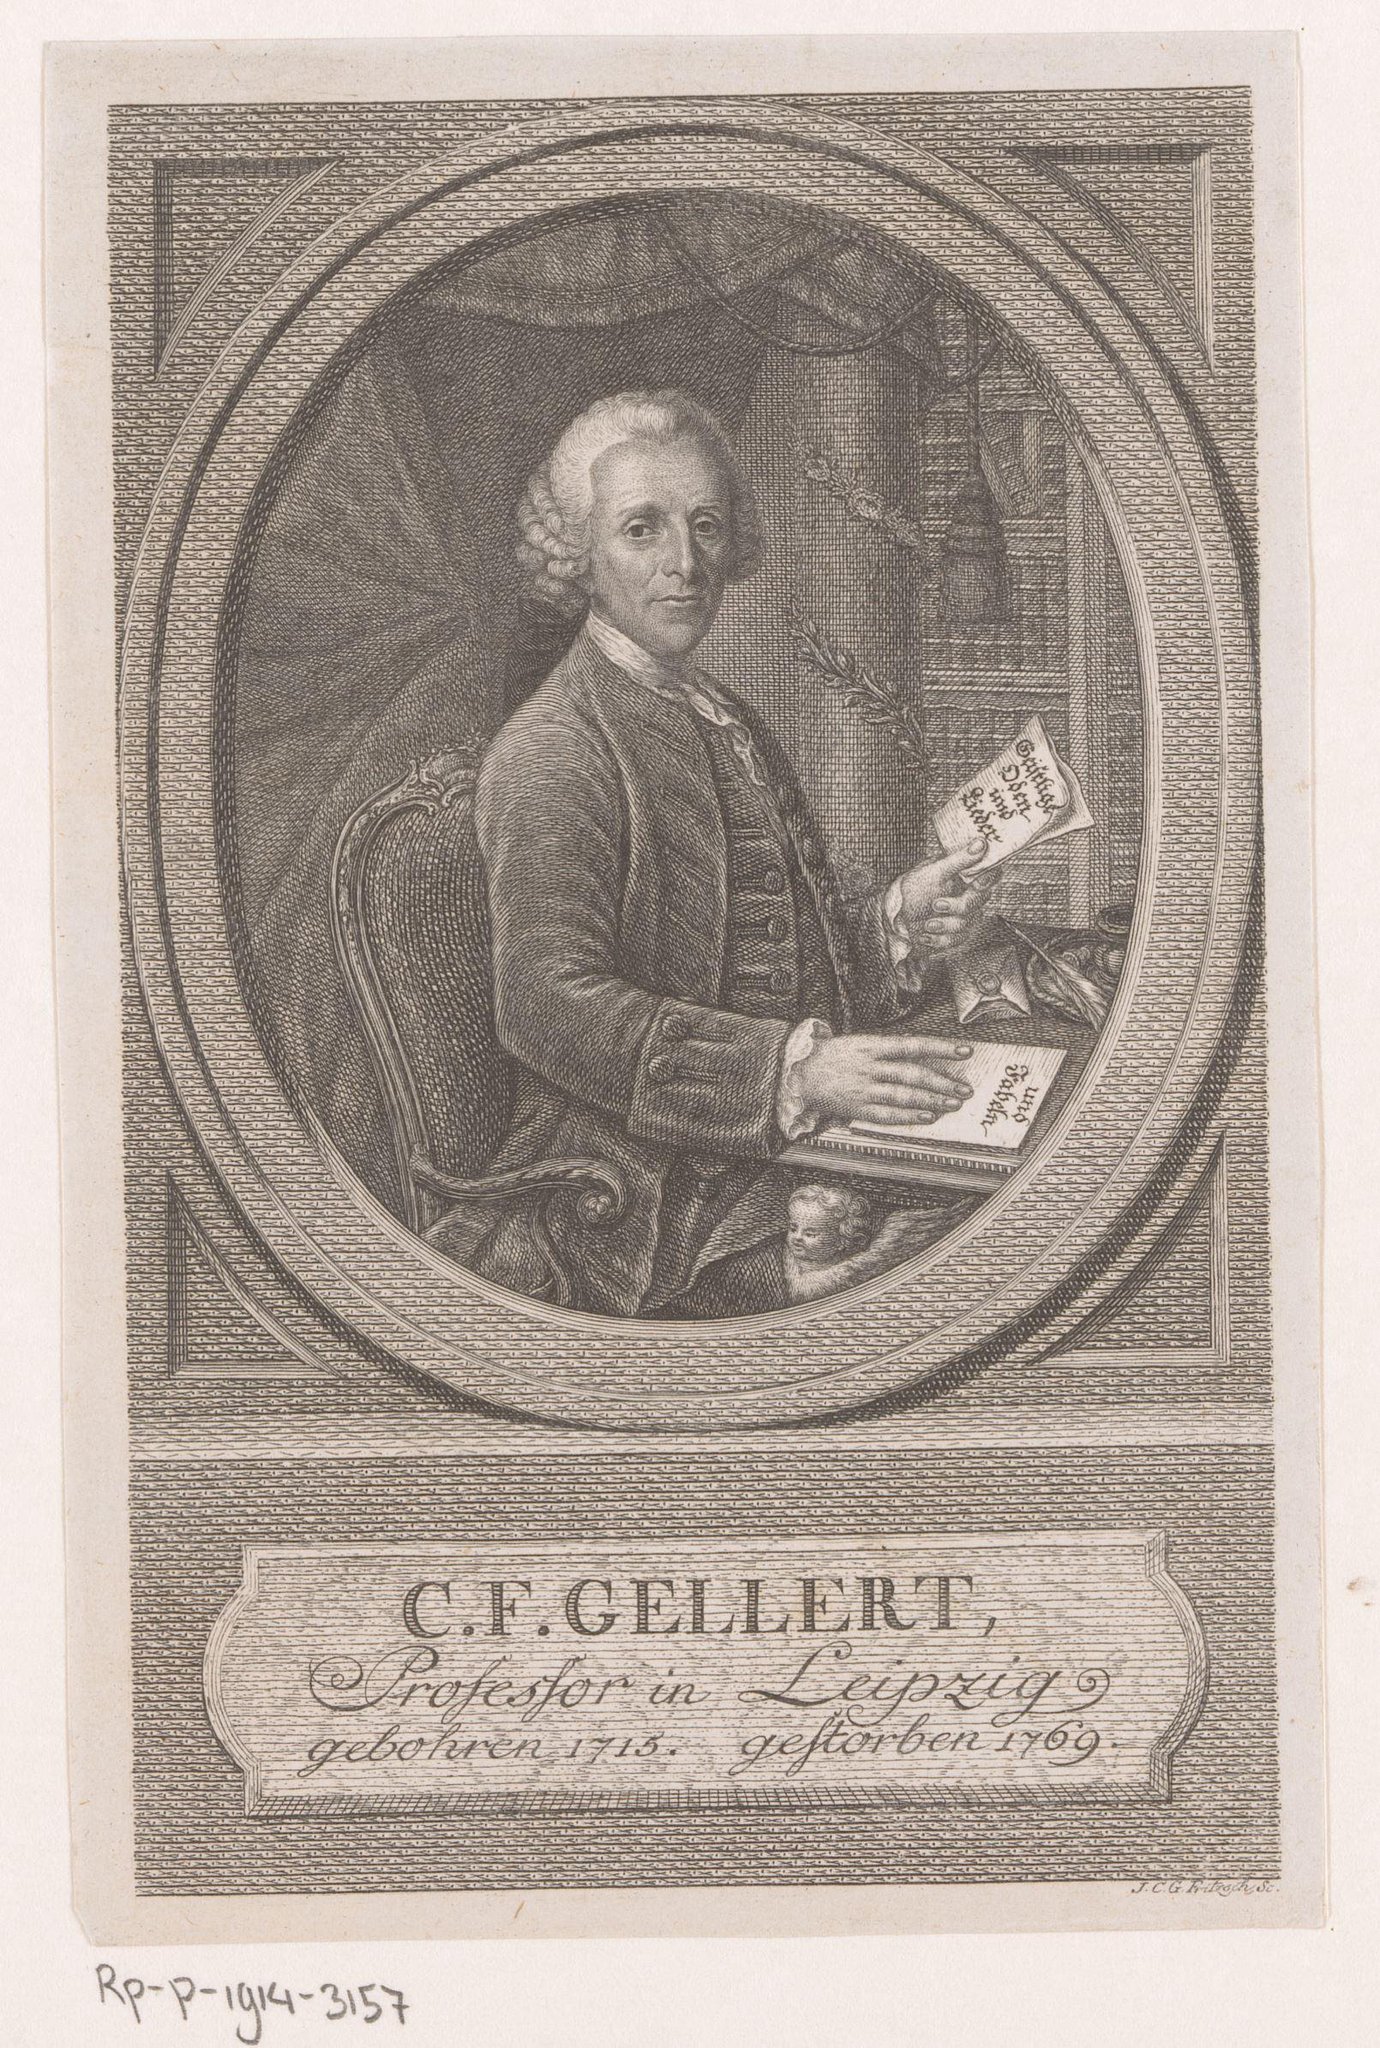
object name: print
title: Portret van Christian Fürchtegott Gellert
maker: johann christian gottfried fritzsch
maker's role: print maker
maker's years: 1720-1802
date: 1769-1802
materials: paper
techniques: engraving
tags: bookshelves, writing tools, historical persons, portrait of a writer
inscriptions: collector's mark: Lugt 2228